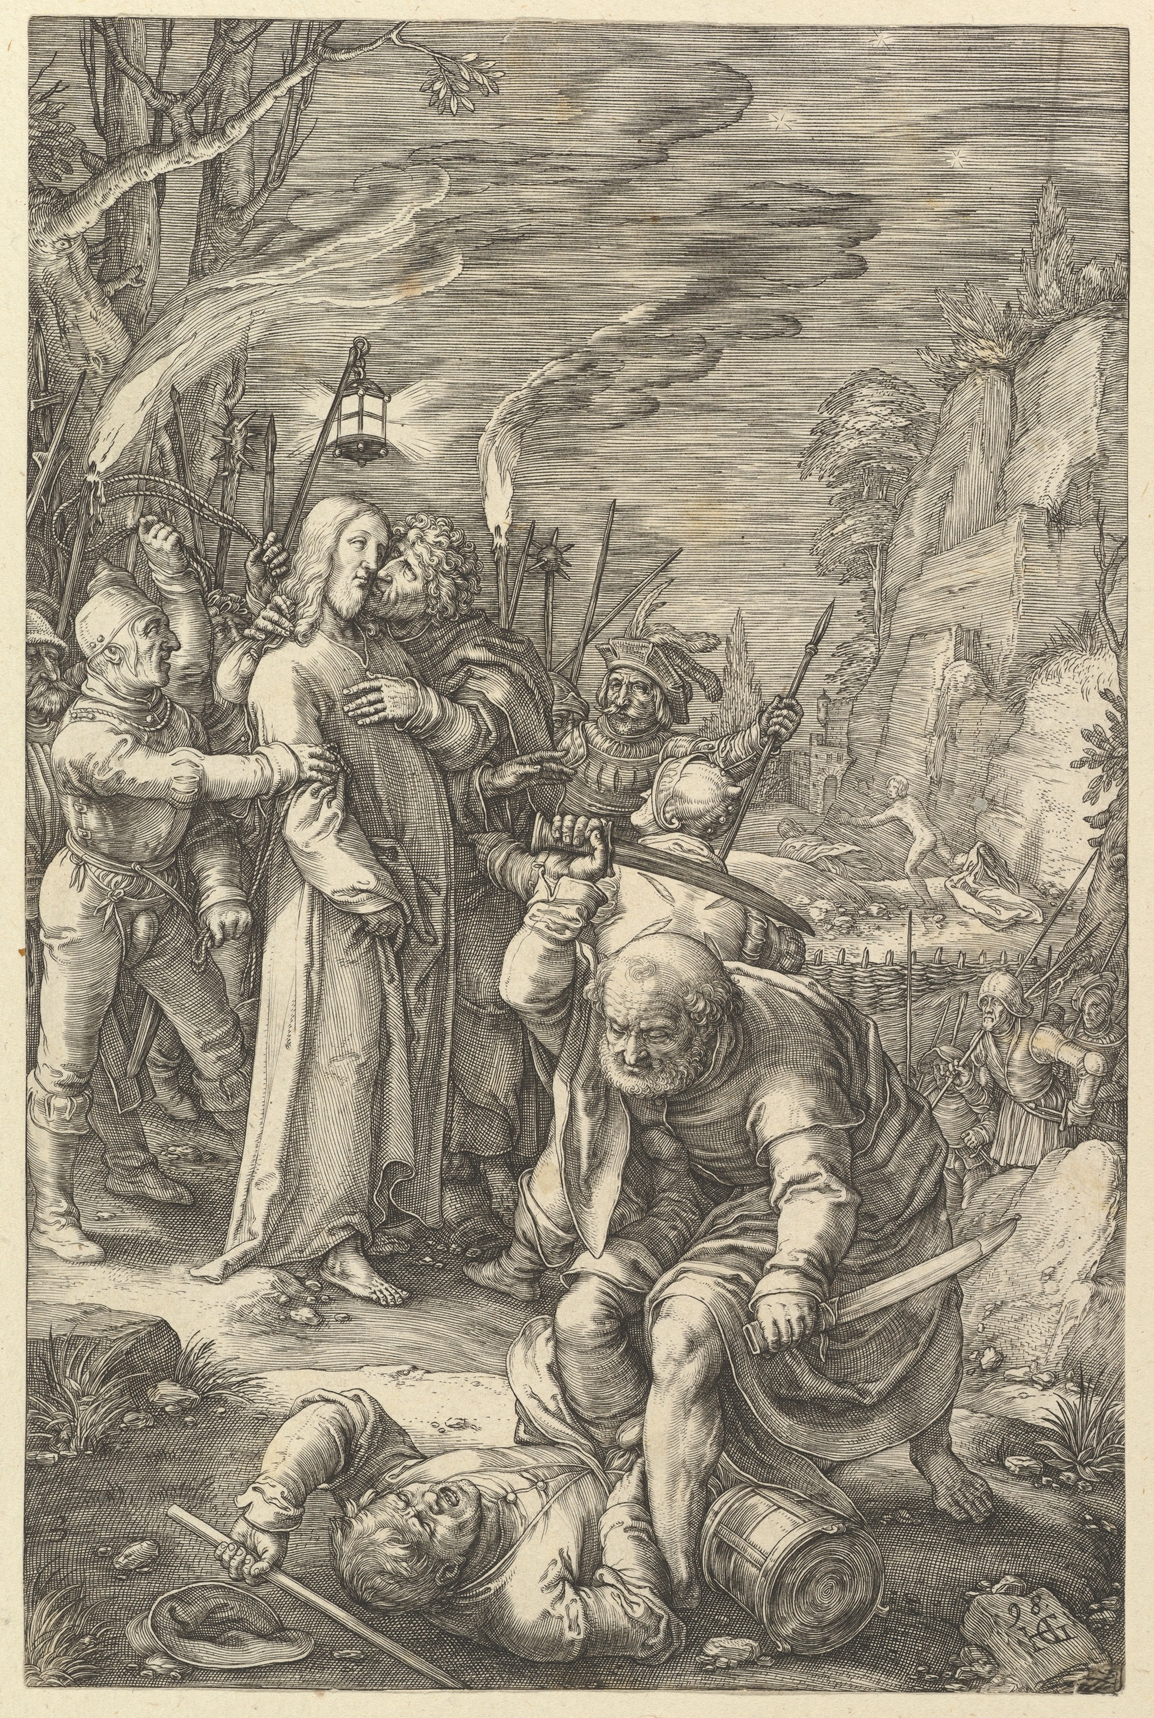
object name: print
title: The Betrayal of Christ, from "The Passion of Christ"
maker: hendrick goltzius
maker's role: artist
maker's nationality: netherlandish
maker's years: 1558-1617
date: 1598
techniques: engraving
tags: men,christ,judas